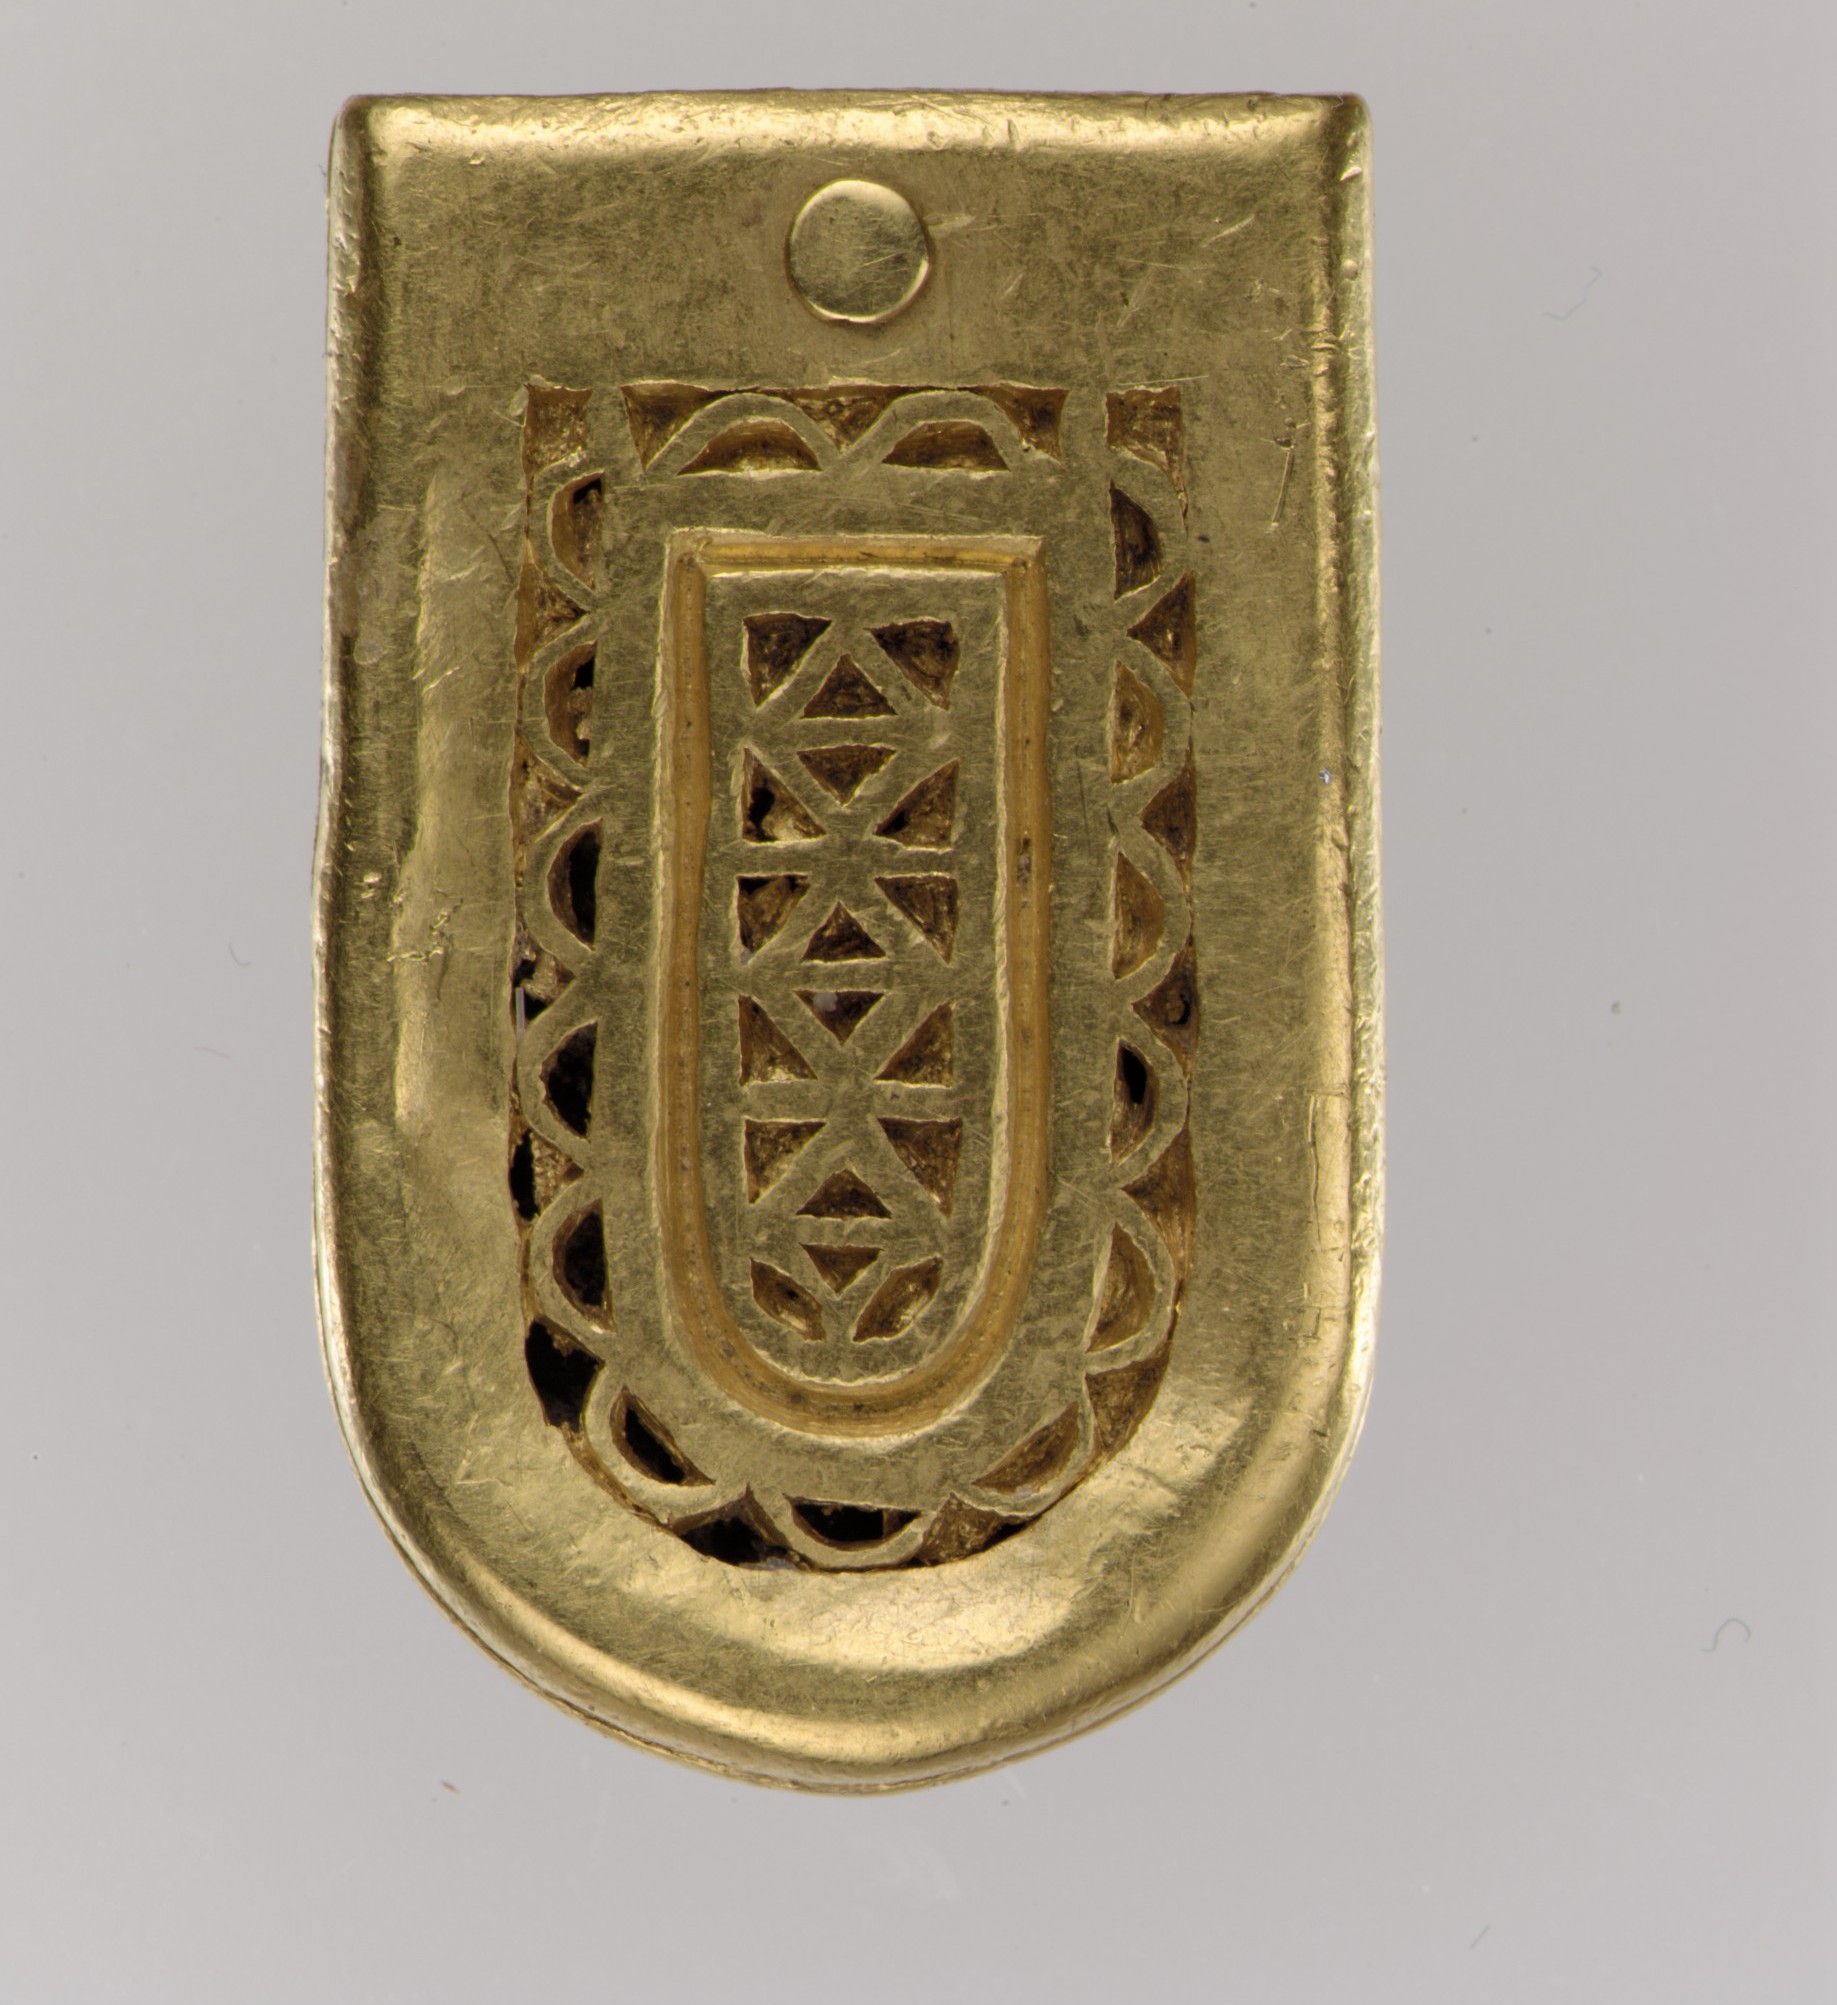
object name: strap end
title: Gold Belt Buckle and Strap End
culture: langobardic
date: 600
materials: gold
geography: constantinople